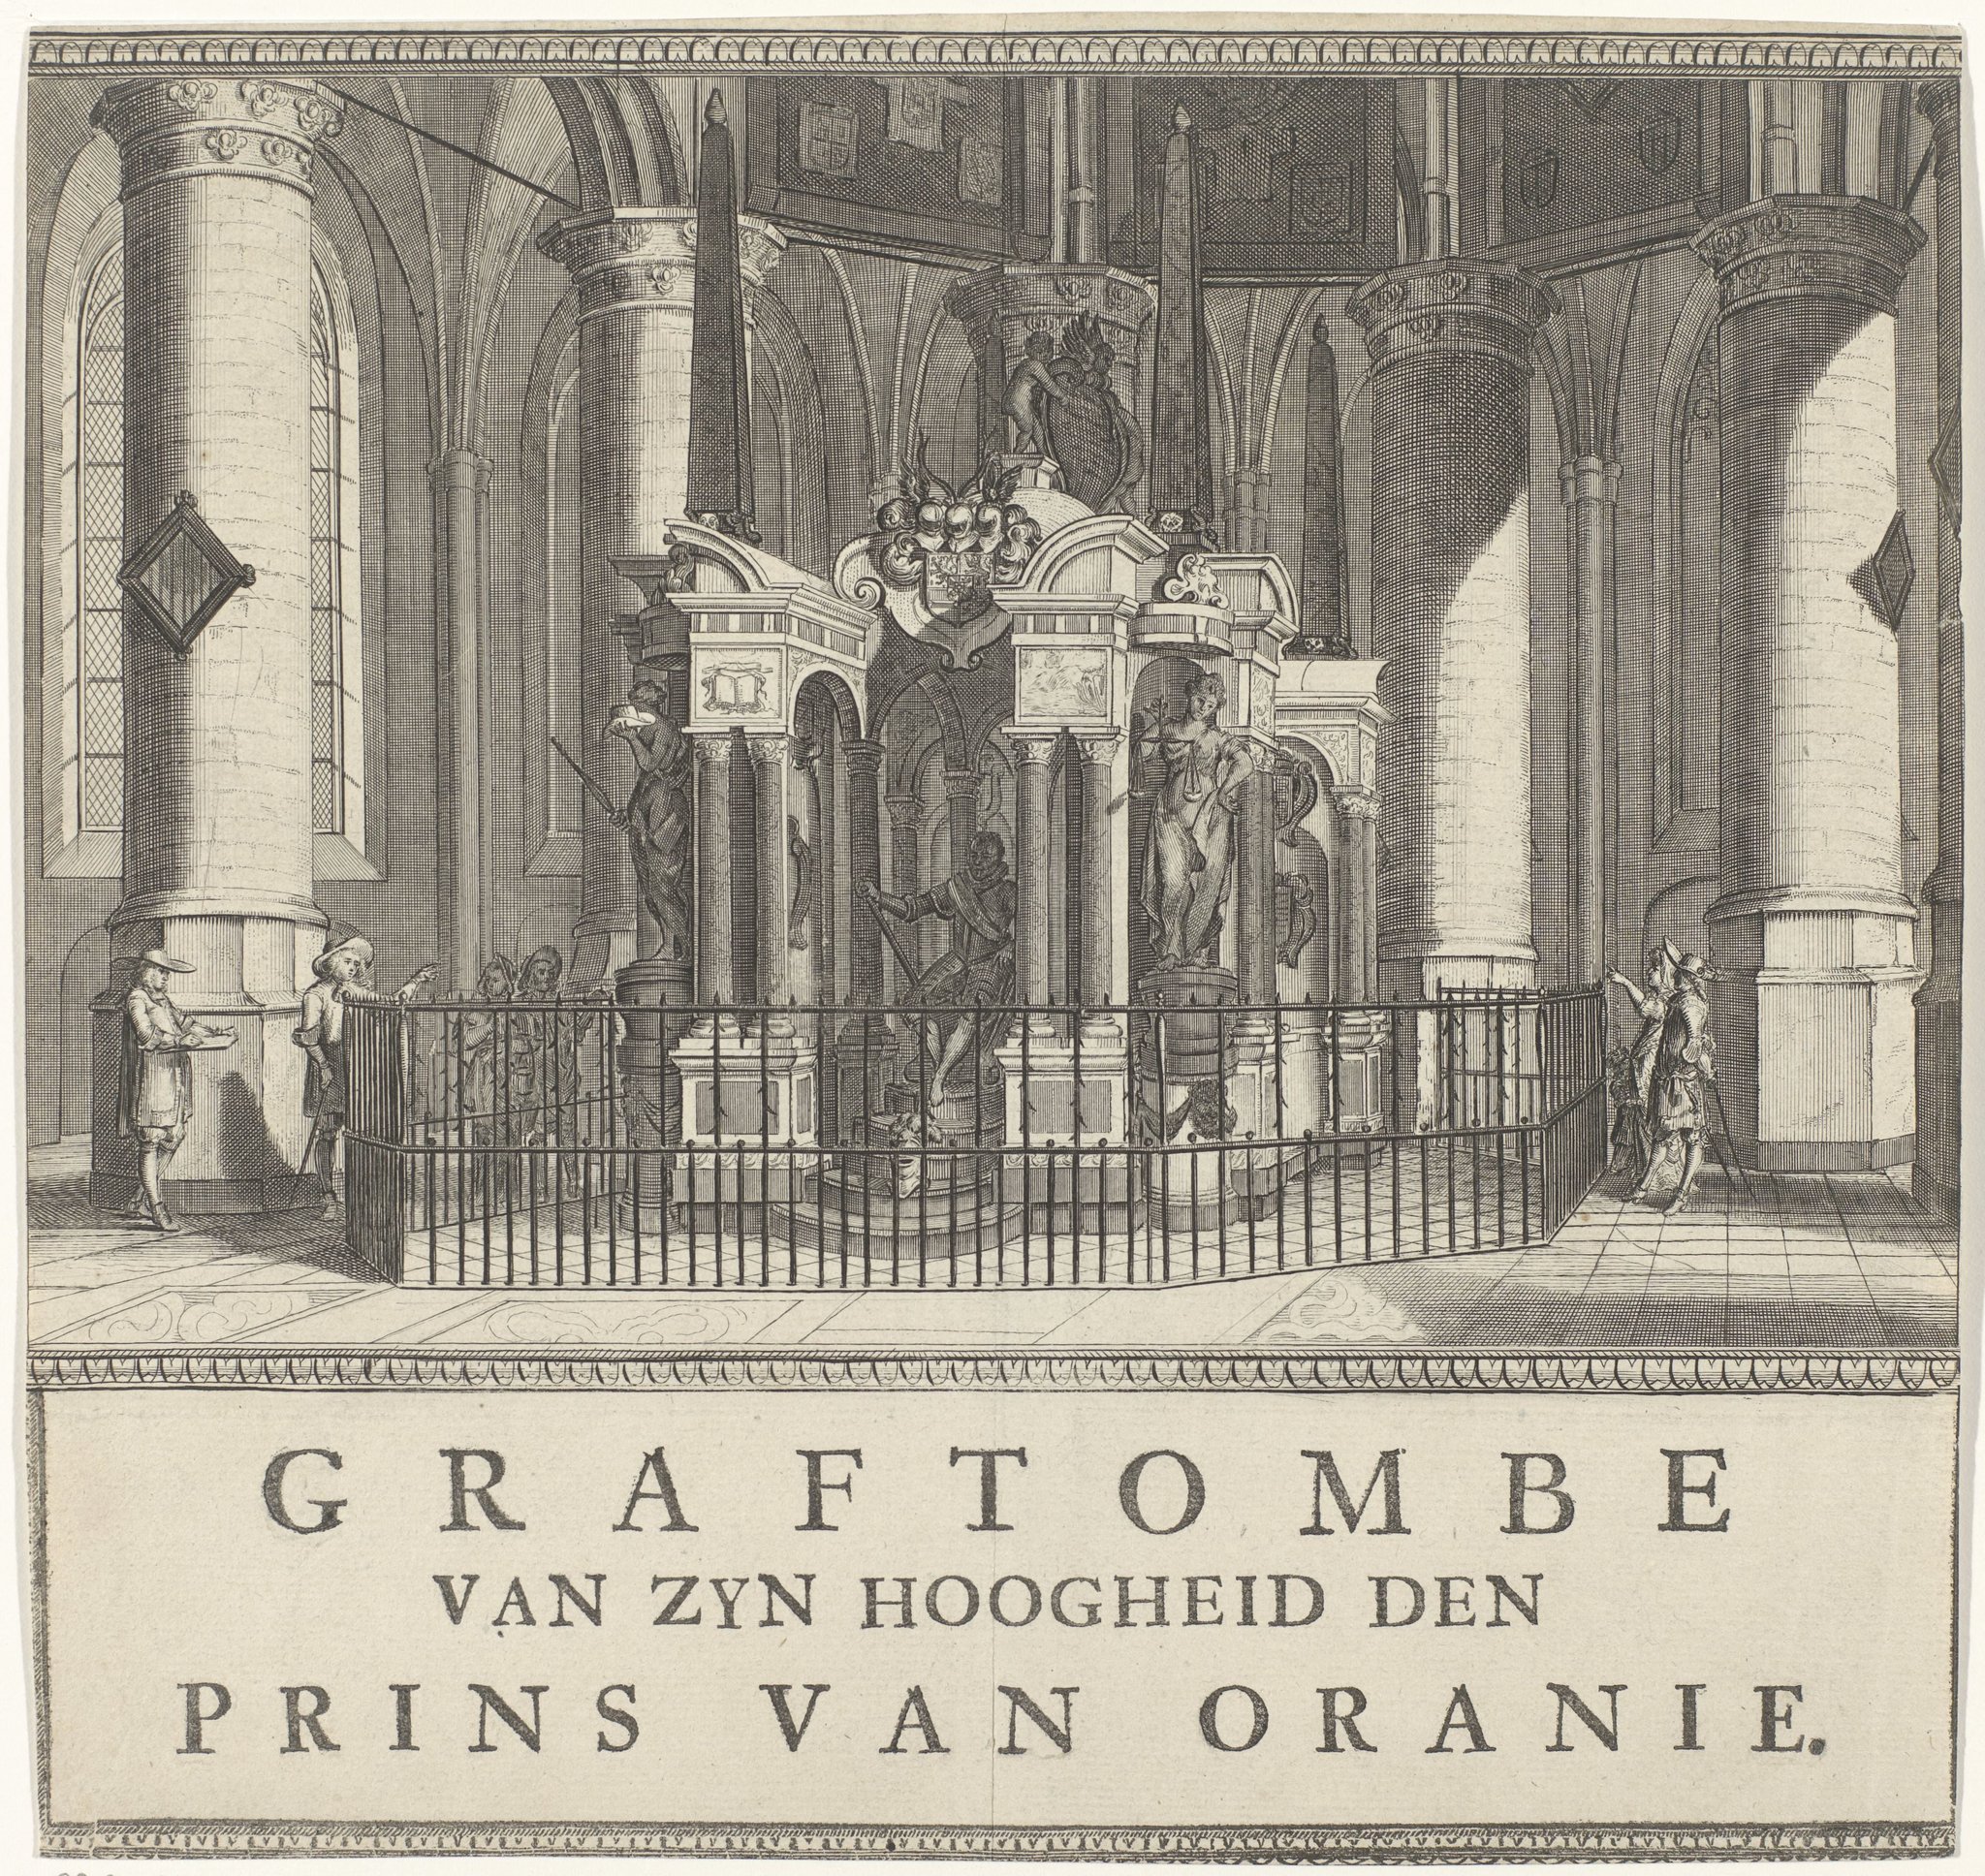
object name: print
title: Graftombe van zyn hoogheid den Prins van Oranie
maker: Anonymous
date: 1700-1799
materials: paper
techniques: etching, letterpress printing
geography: low countries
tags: william i (prince of orange), historical persons, interior of church, grave-building, monumental tomb, delft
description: Graftombe of praalgraf van Willem I in de Nieuwe Kerk te Delft, voltooid in 1623. Gezien van voren met het beeld van de zittende prins. Met de omlijsting en met een apart gedrukte titel tegen de onderzijde van de voorstelling.